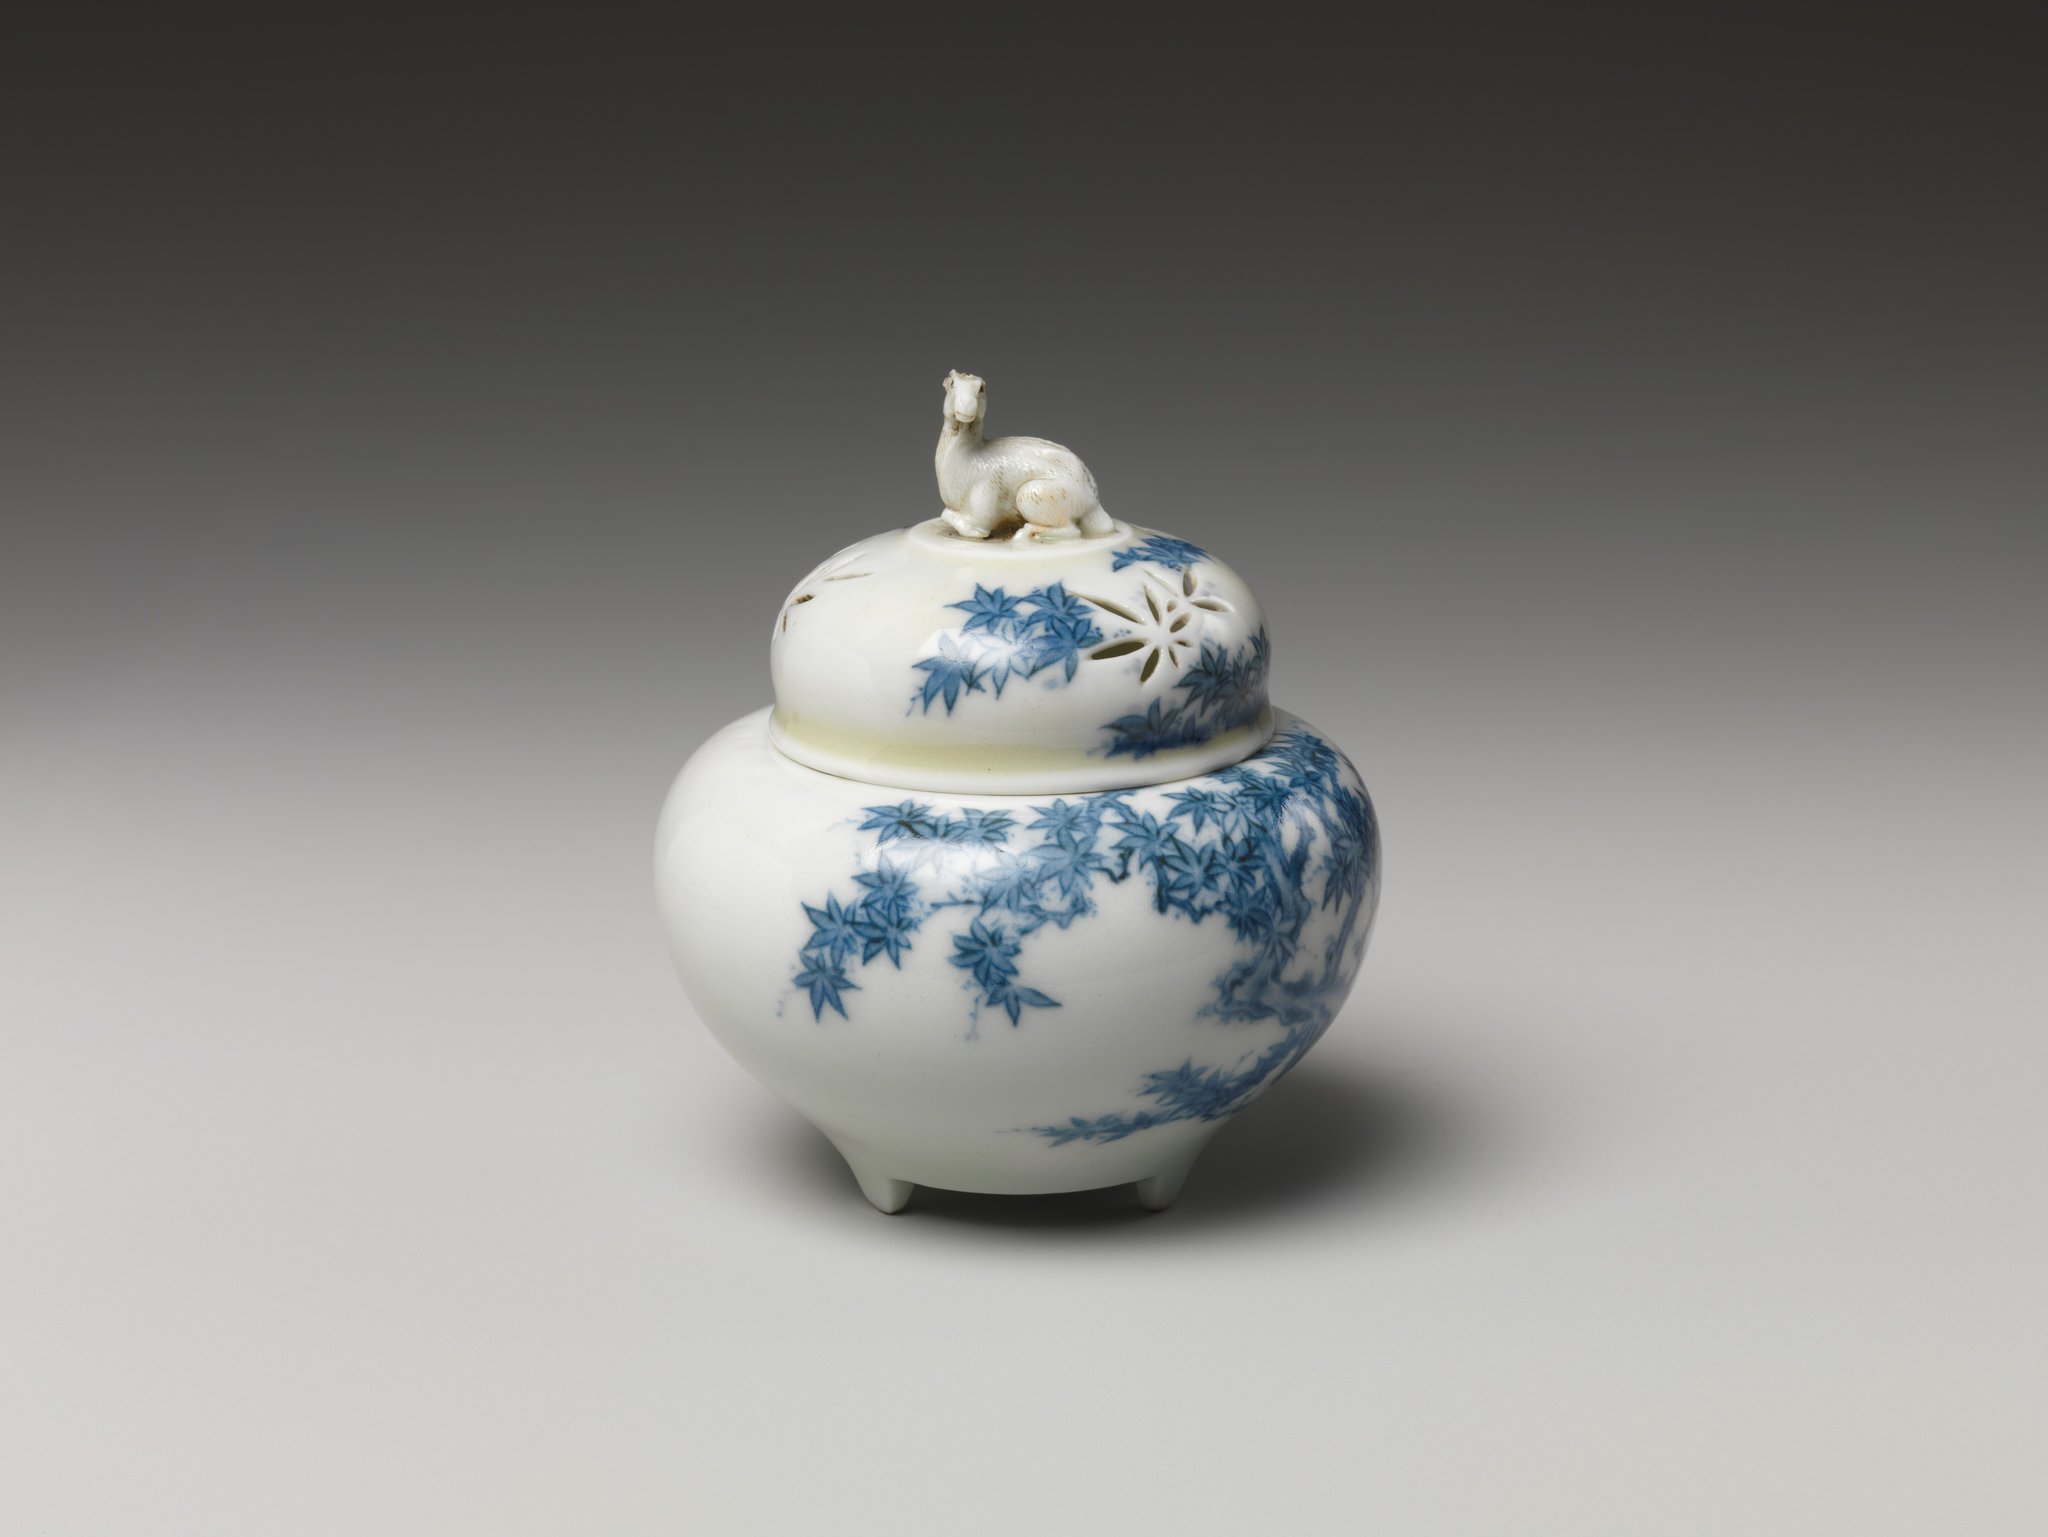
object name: incense burner with cover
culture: japanese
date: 1750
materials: glaze, porcelain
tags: horses